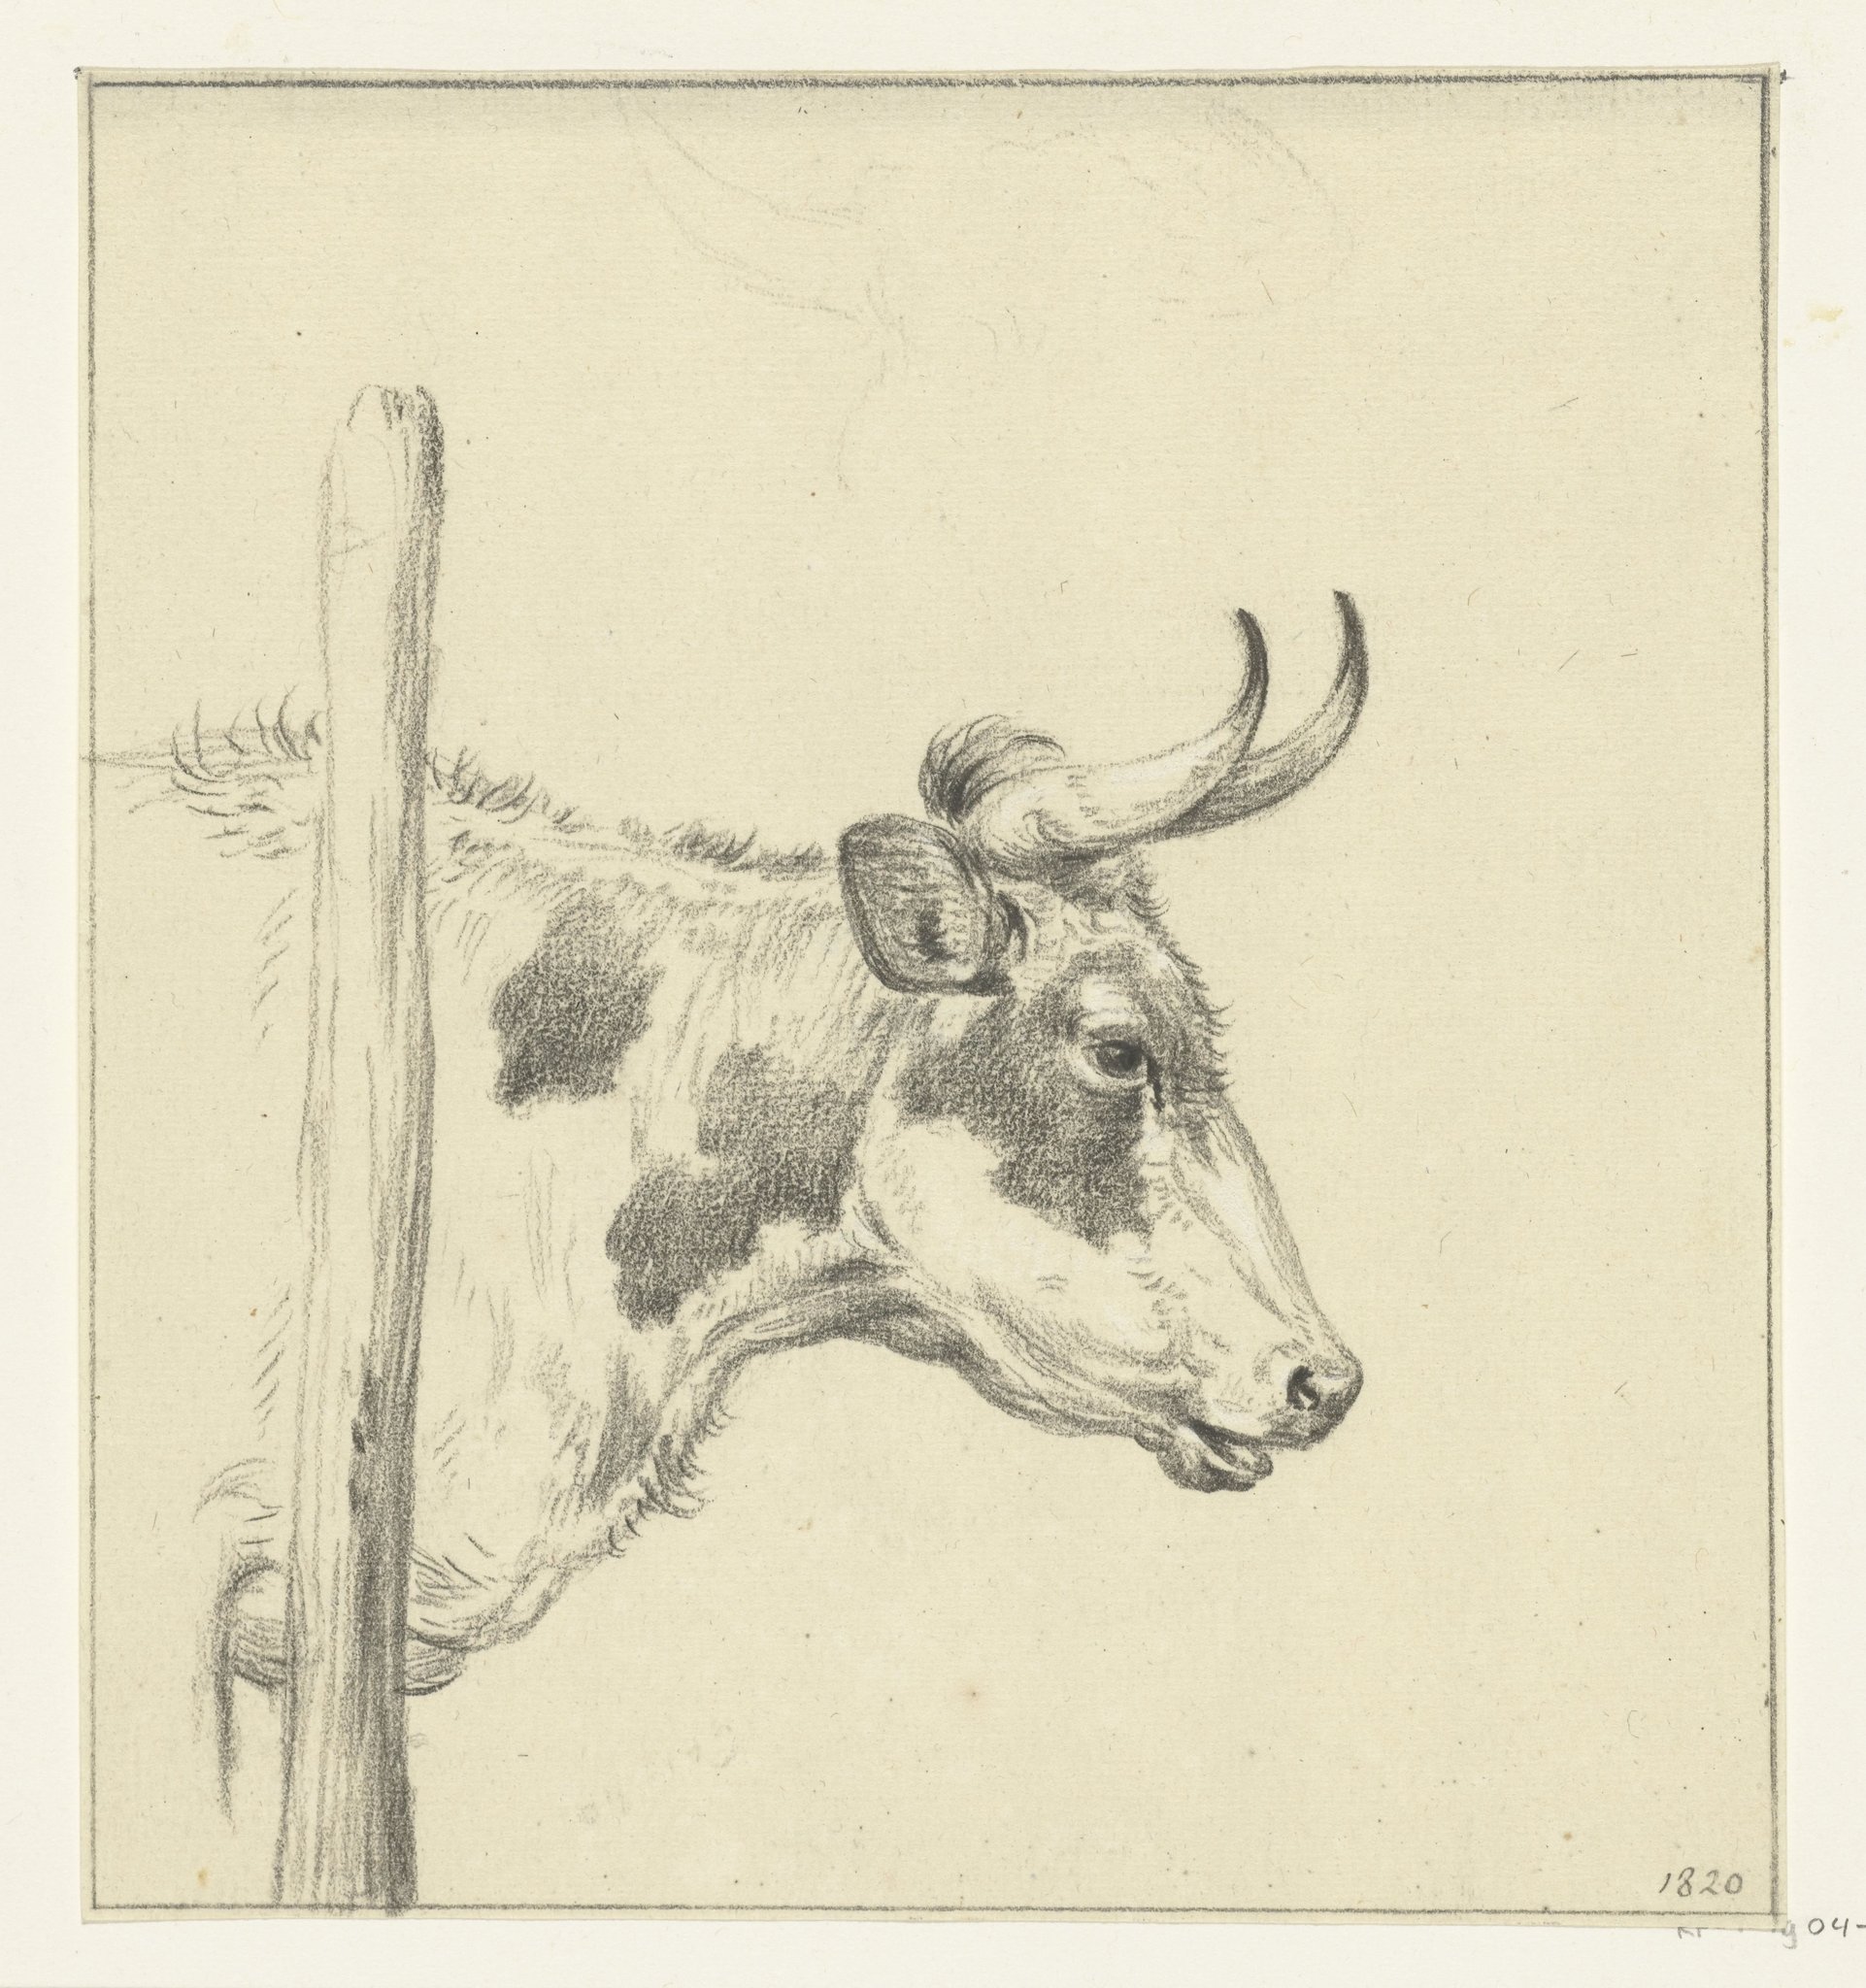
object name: drawing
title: Kop van een koe, naar rechts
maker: jean bernard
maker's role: draughtsman, print maker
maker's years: 1765-1833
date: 1820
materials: chalk, paper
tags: cow